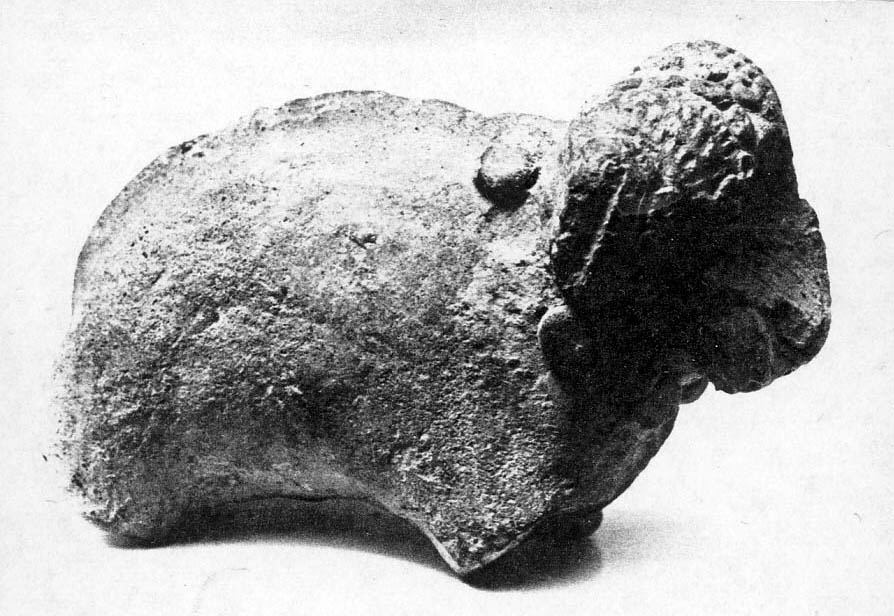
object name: statuette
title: Figure of a Ram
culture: indian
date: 1-200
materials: terracotta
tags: shunga,rams